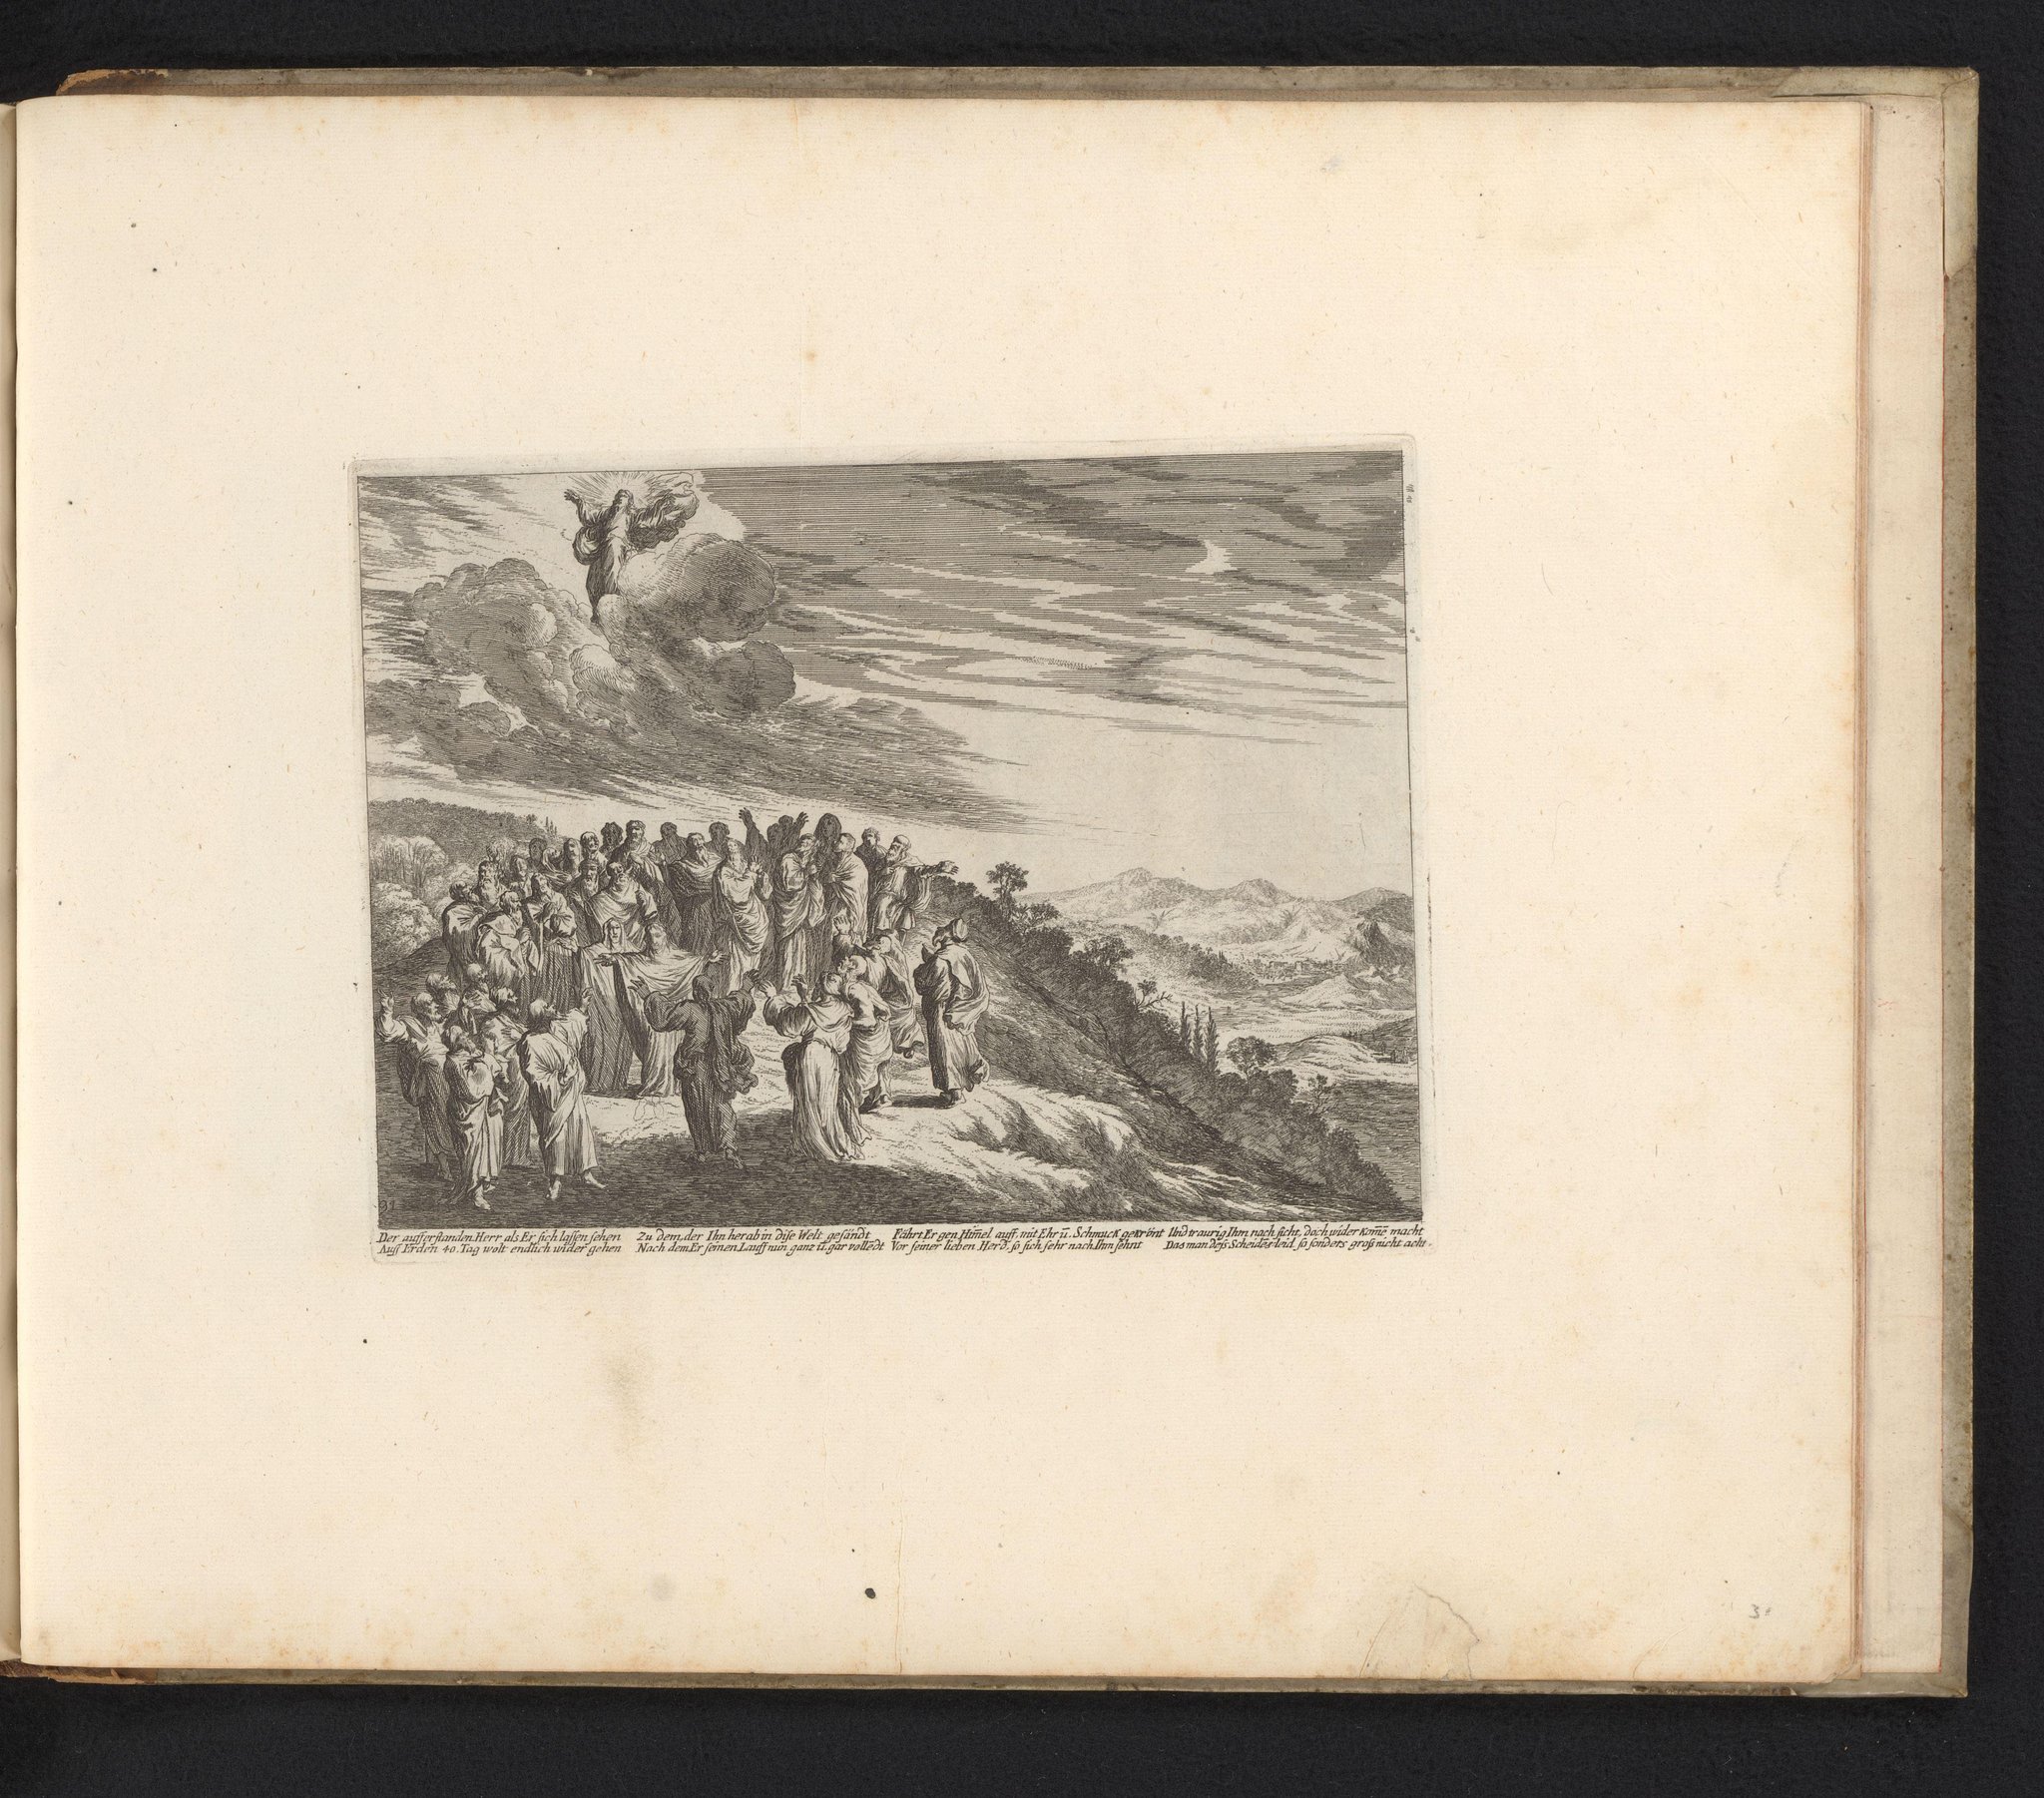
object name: album leaf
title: Hemelvaart van Christus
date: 1670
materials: paper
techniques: etching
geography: augsburg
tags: christ ascends into heaven; apostles (and mary) beneath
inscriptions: collector's mark: Lugt 2228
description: Tekst in het Duits in de ondermarge. Linksonder genummerd: 31. Prent maakt deel uit van een album.